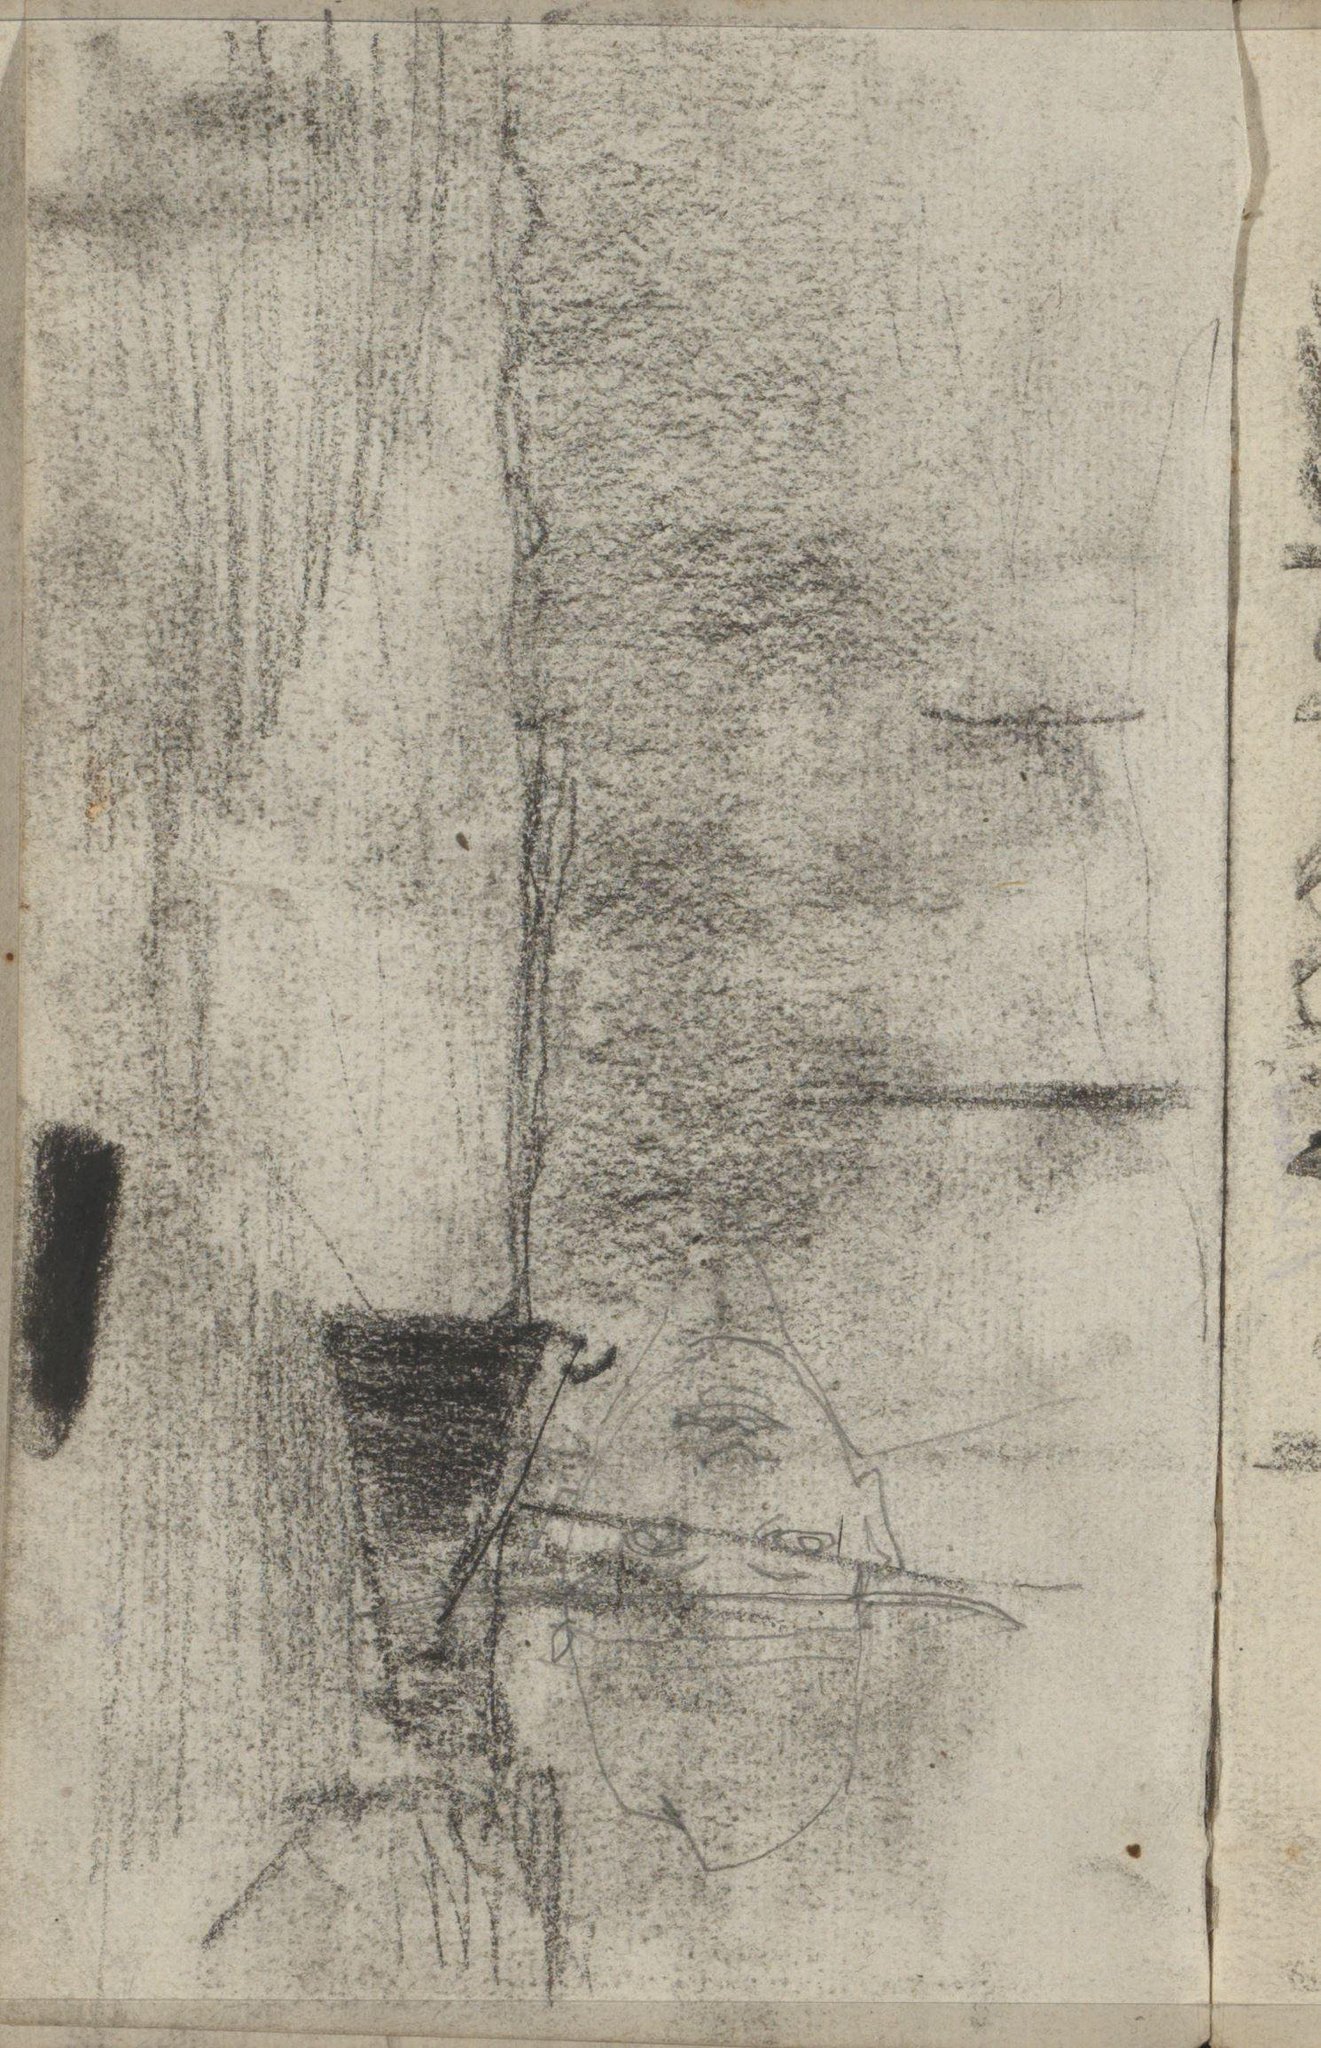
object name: sketchbook leaf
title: Schip in het water en een mannenhoofd met hoed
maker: george hendrik breitner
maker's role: draughtsman, painter, print maker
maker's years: 1857-1923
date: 1887-1889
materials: chalk, paper, pencil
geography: amsterdam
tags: head (human), landscapes with waters, waterscapes, seascapes (in the temperate zone), ships (in general)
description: Pagina 21 uit een schetsboek met 27 bladen.